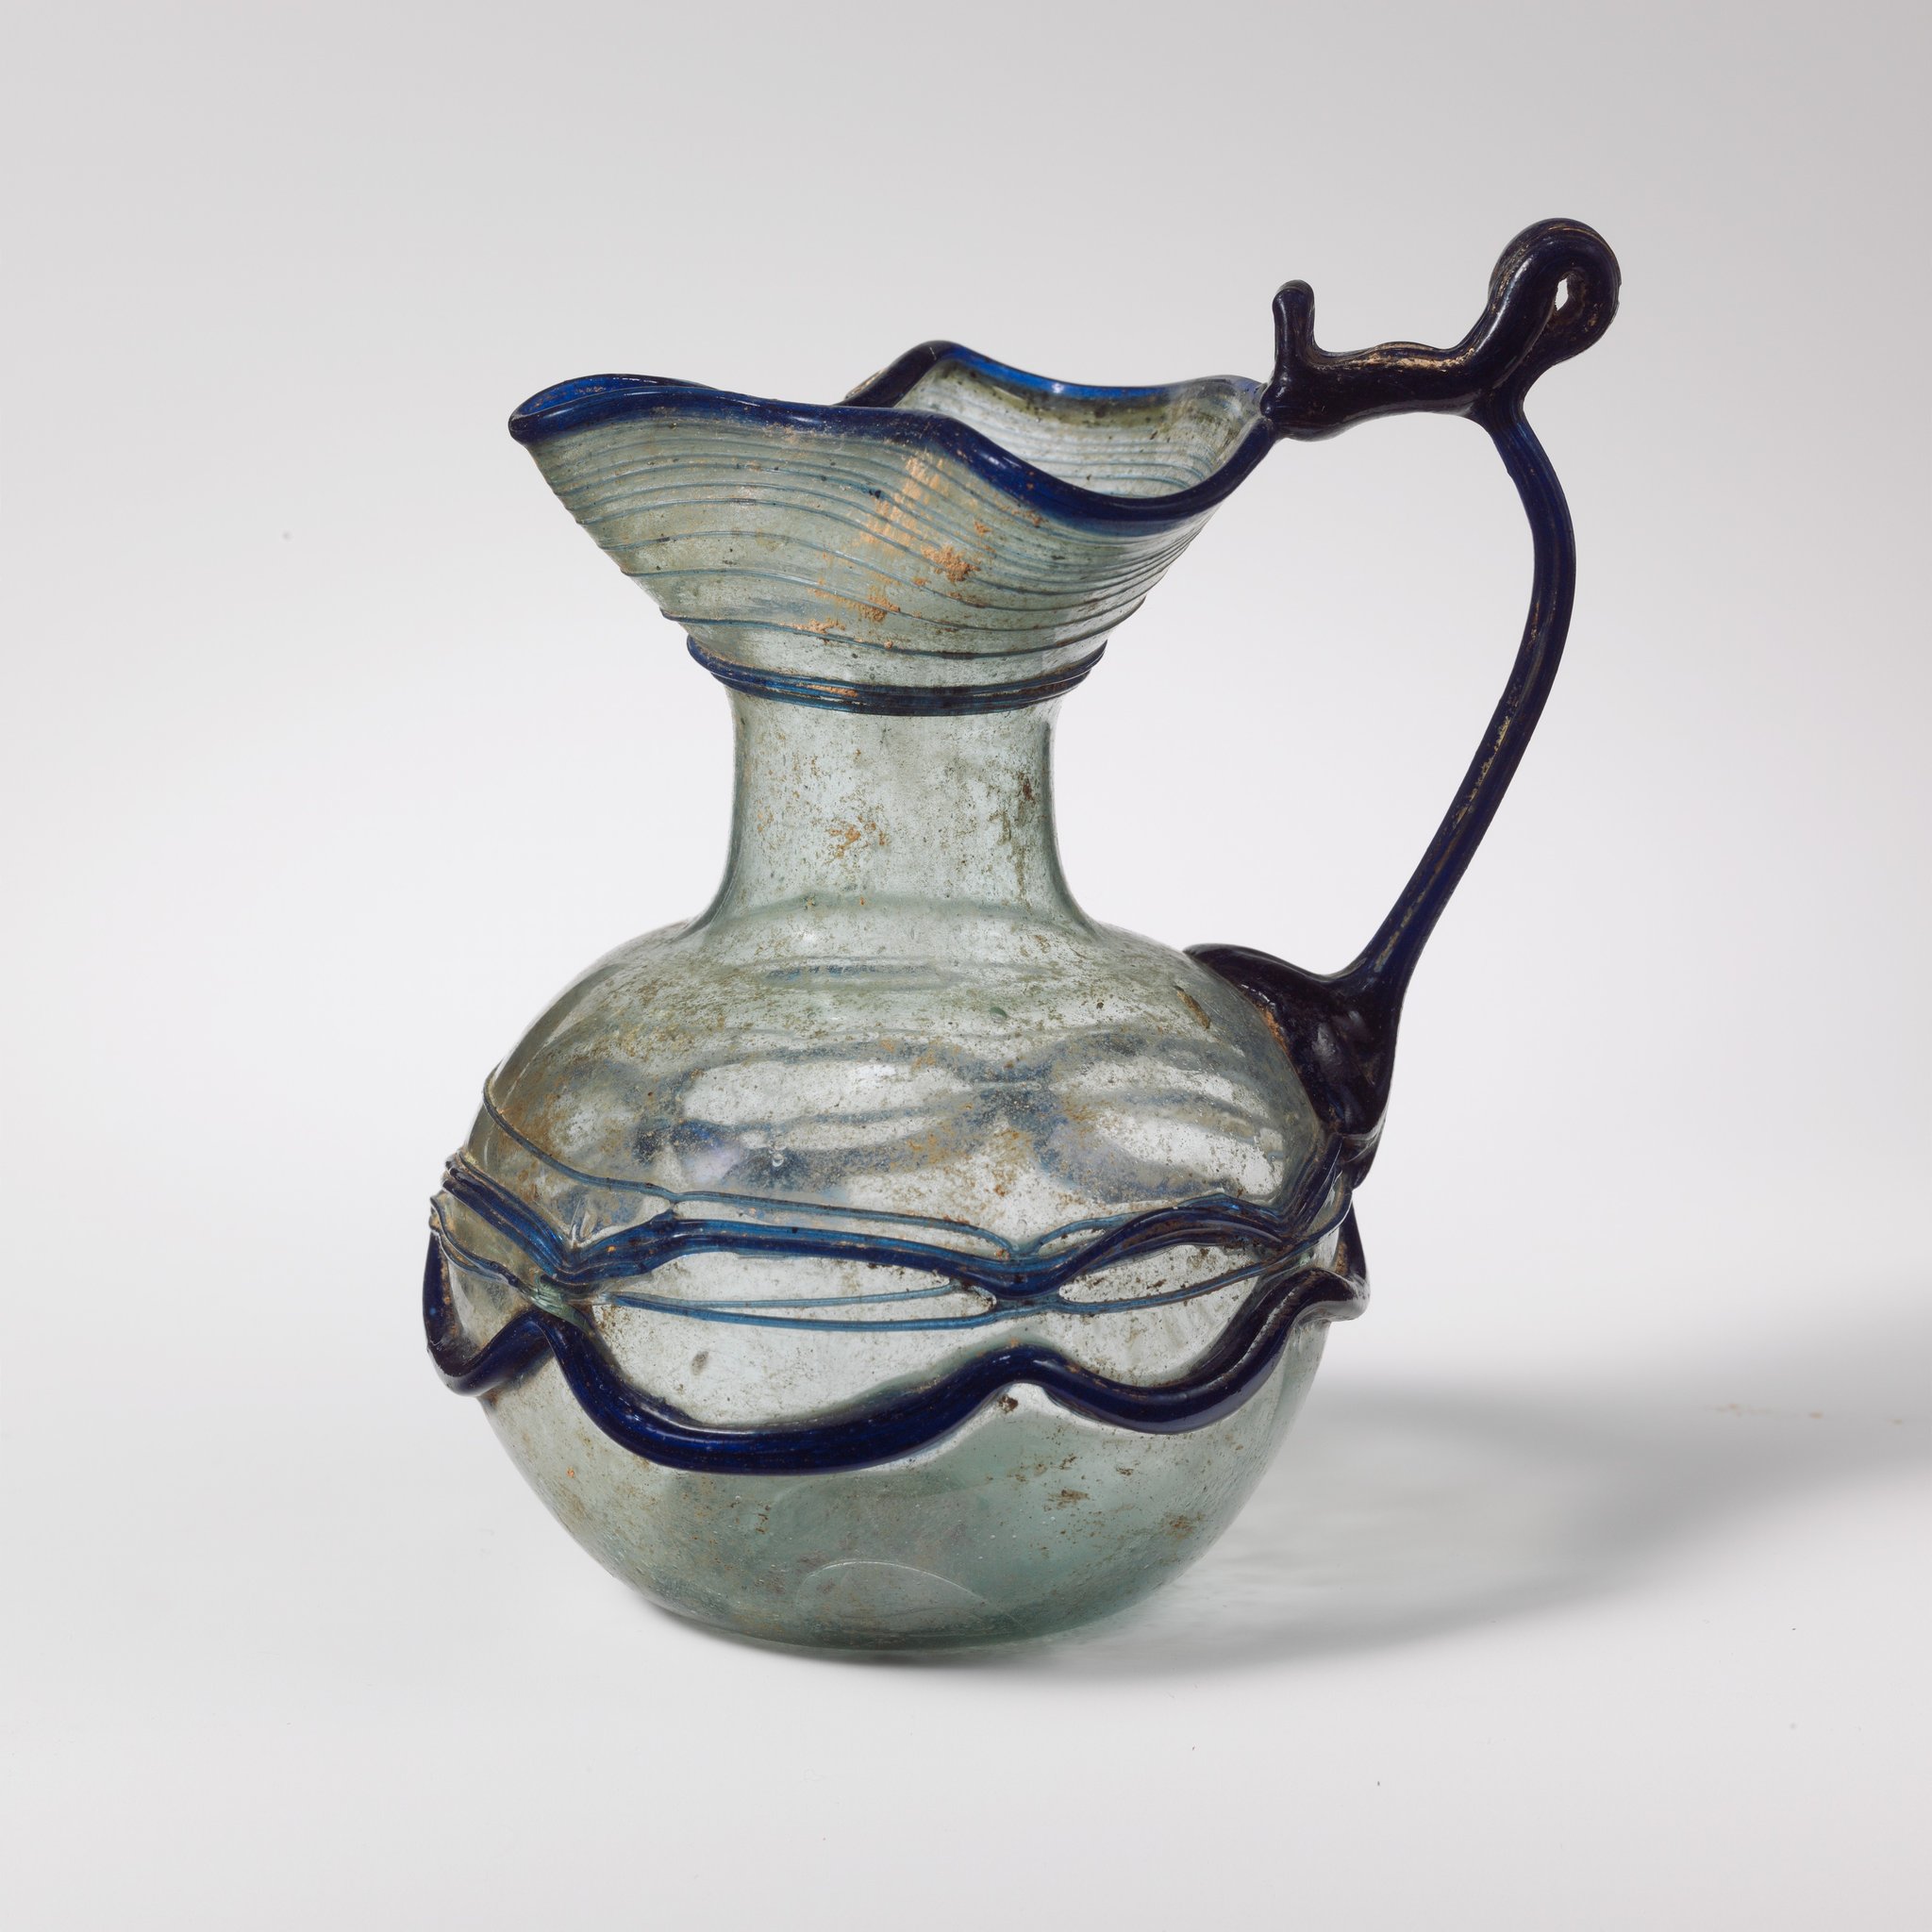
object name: jug with trefoil rim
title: Glass jug with trefoil rim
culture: roman, syrian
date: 401-600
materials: glass